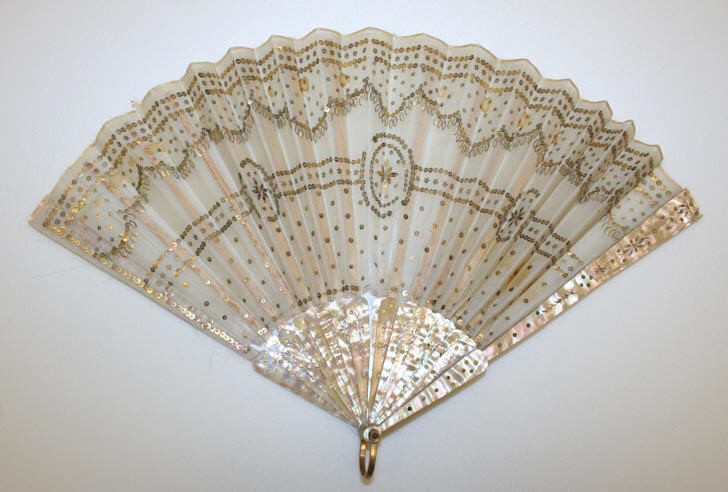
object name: fan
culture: french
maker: goossens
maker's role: designer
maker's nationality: french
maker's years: 1950-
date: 1870-1879